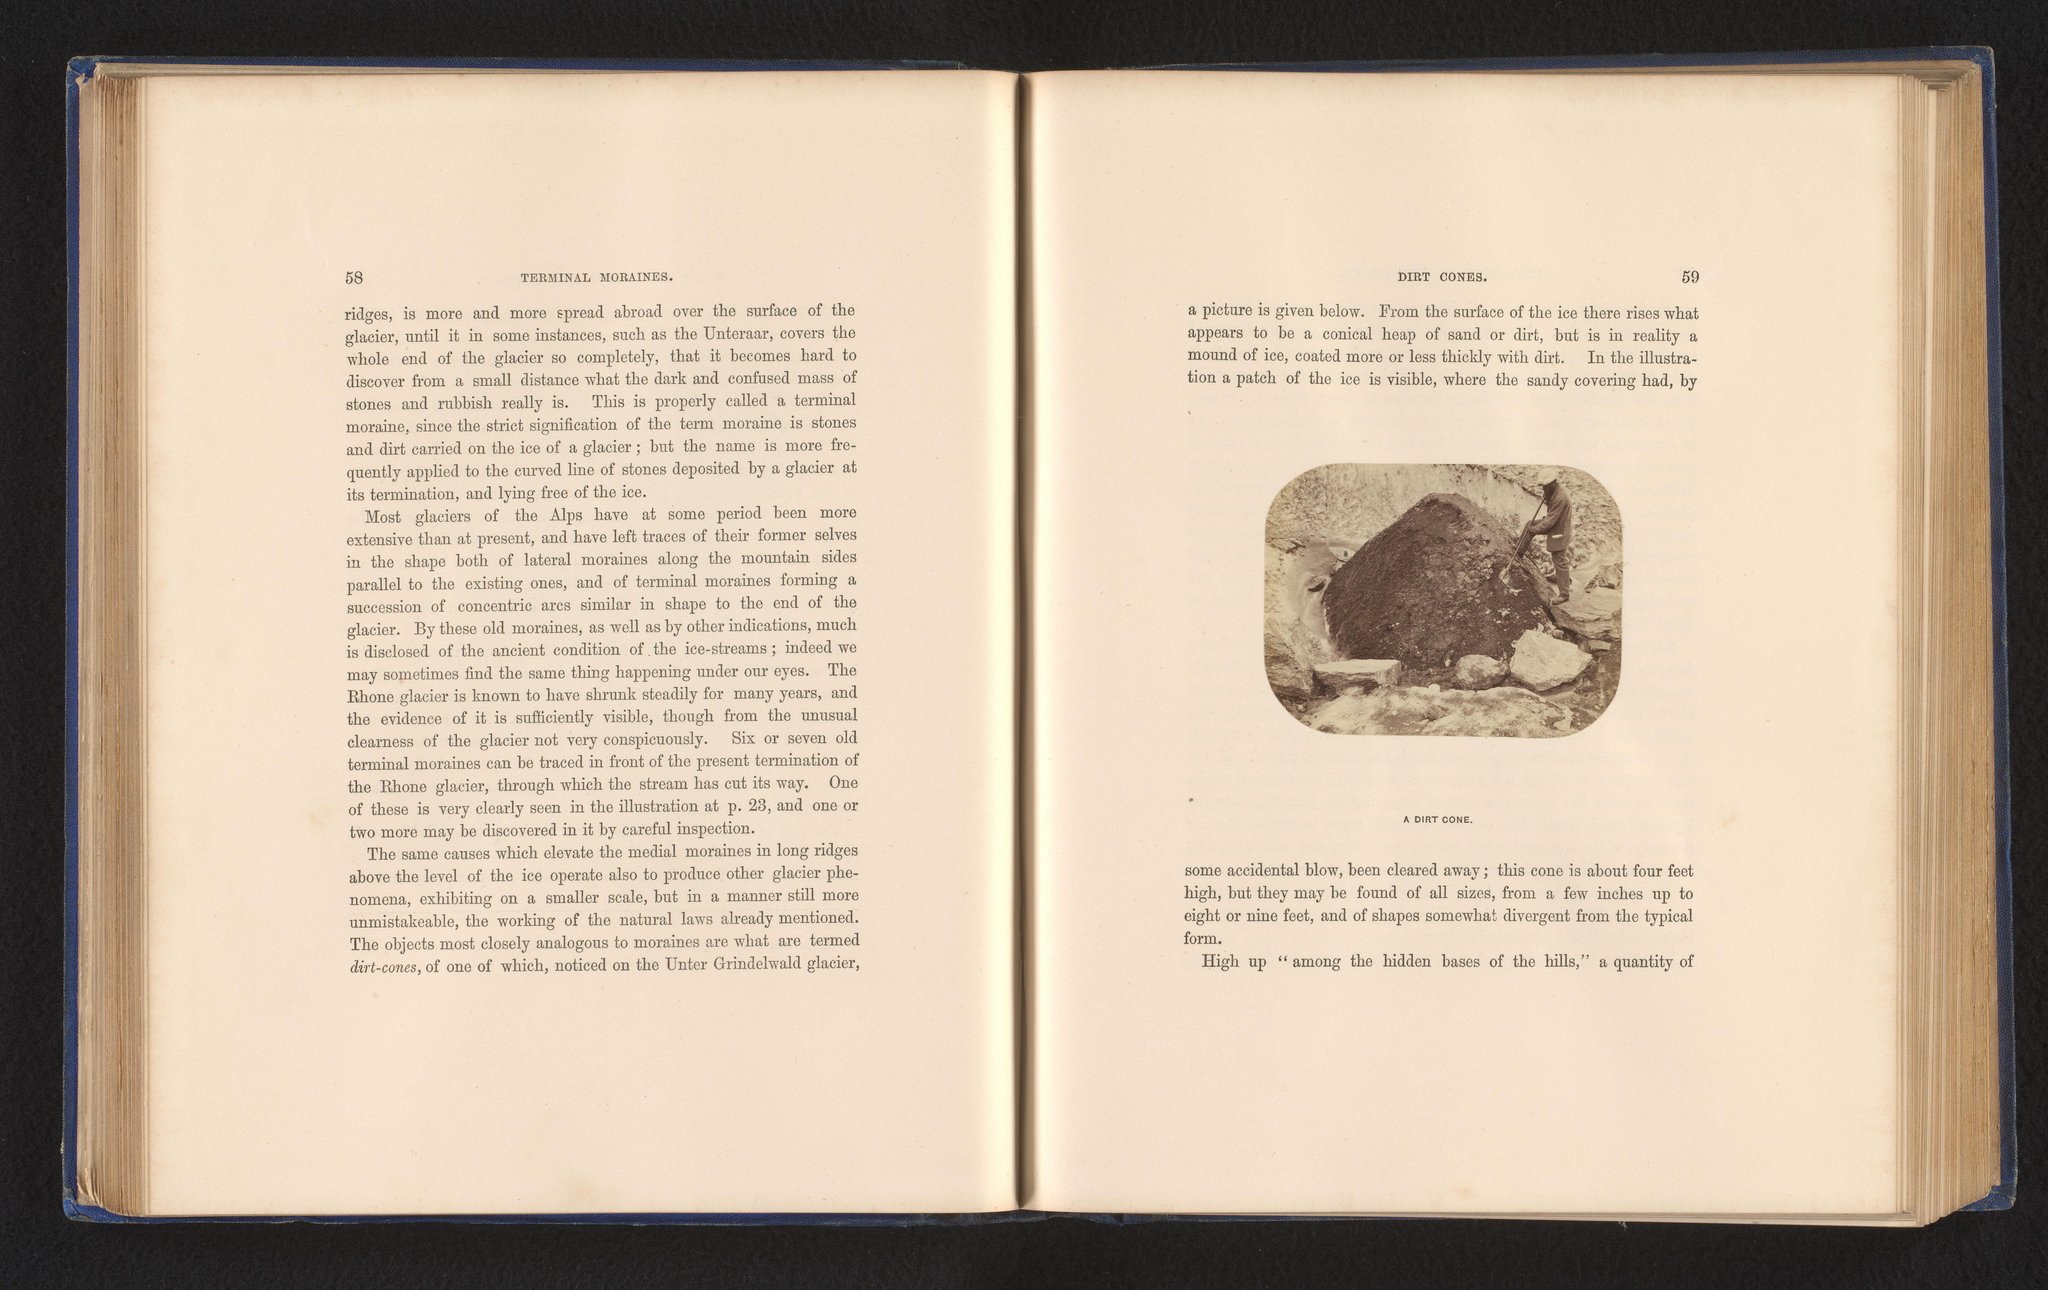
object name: photograph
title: Man bij een berg puin in het Berner Oberland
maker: ernest edwards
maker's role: fotograaf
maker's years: 1837-1903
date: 1861-1866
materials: paper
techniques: albumen print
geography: berner oberland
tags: adult man